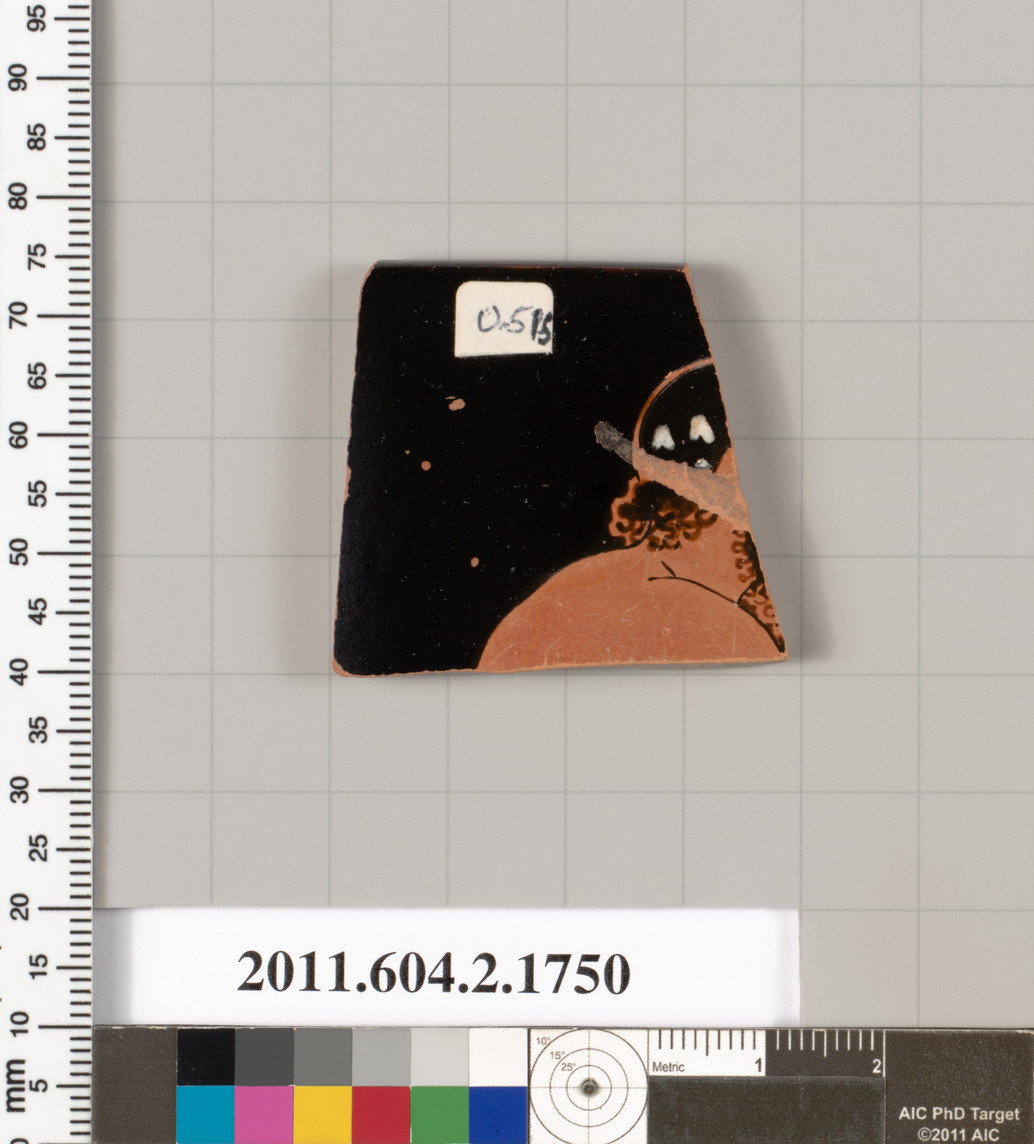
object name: skyphos fragment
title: Terracotta rim fragment of a skyphos (deep drinking cup)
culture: greek, attic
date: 460-440 BCE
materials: terracotta